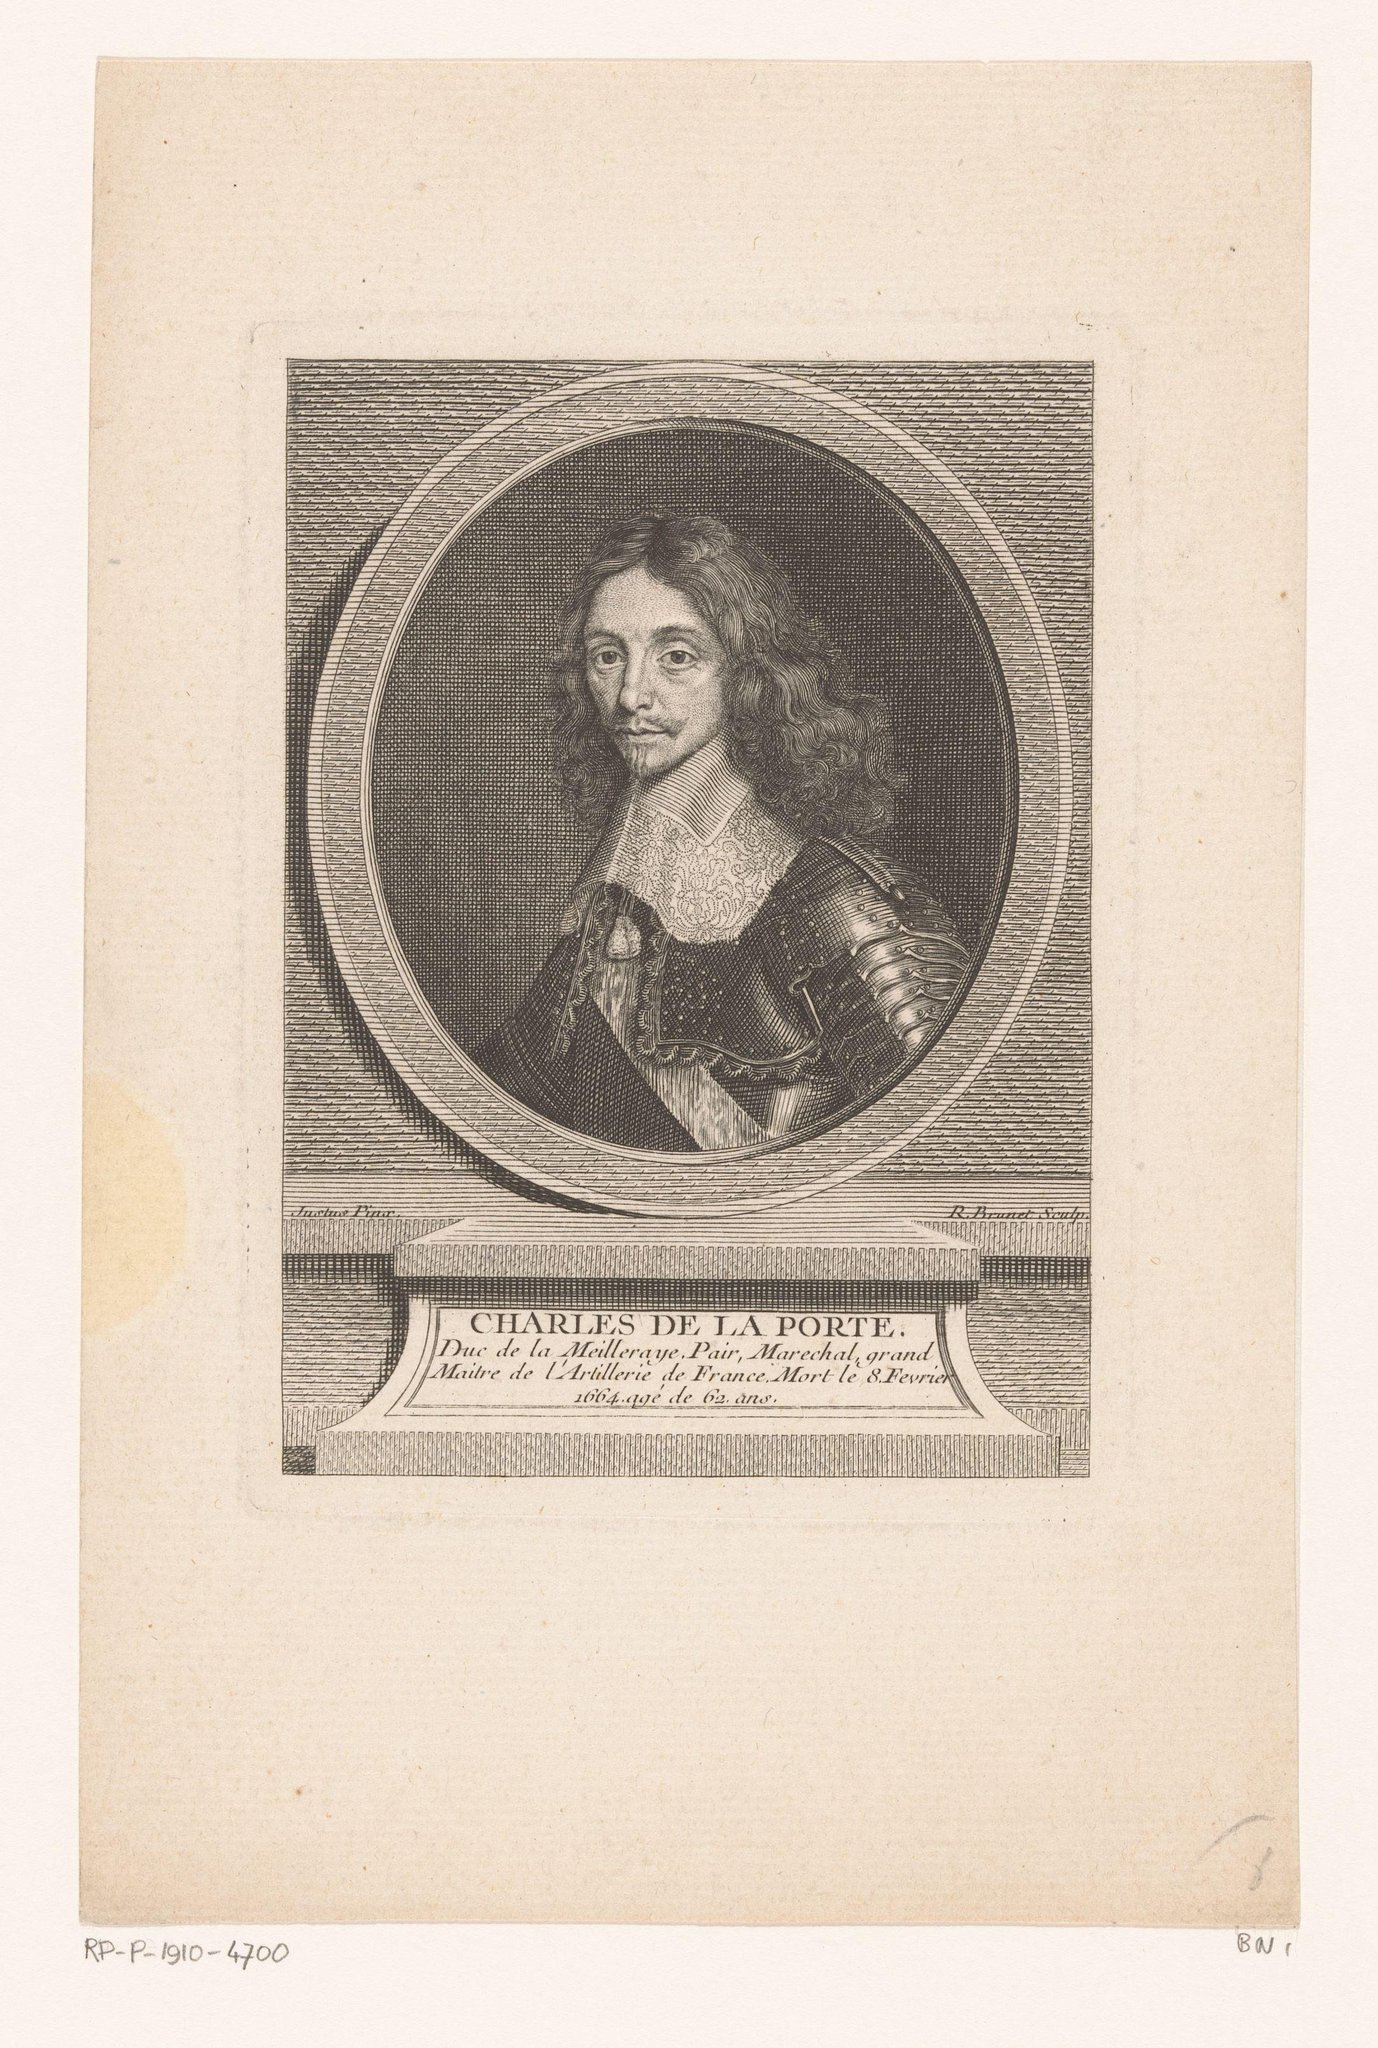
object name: print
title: Portret van Charles de la Porte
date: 1700-1799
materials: paper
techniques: engraving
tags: paris, charles de la porte, ranks in the army, armour, historical persons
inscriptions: collector's mark: Lugt 2228